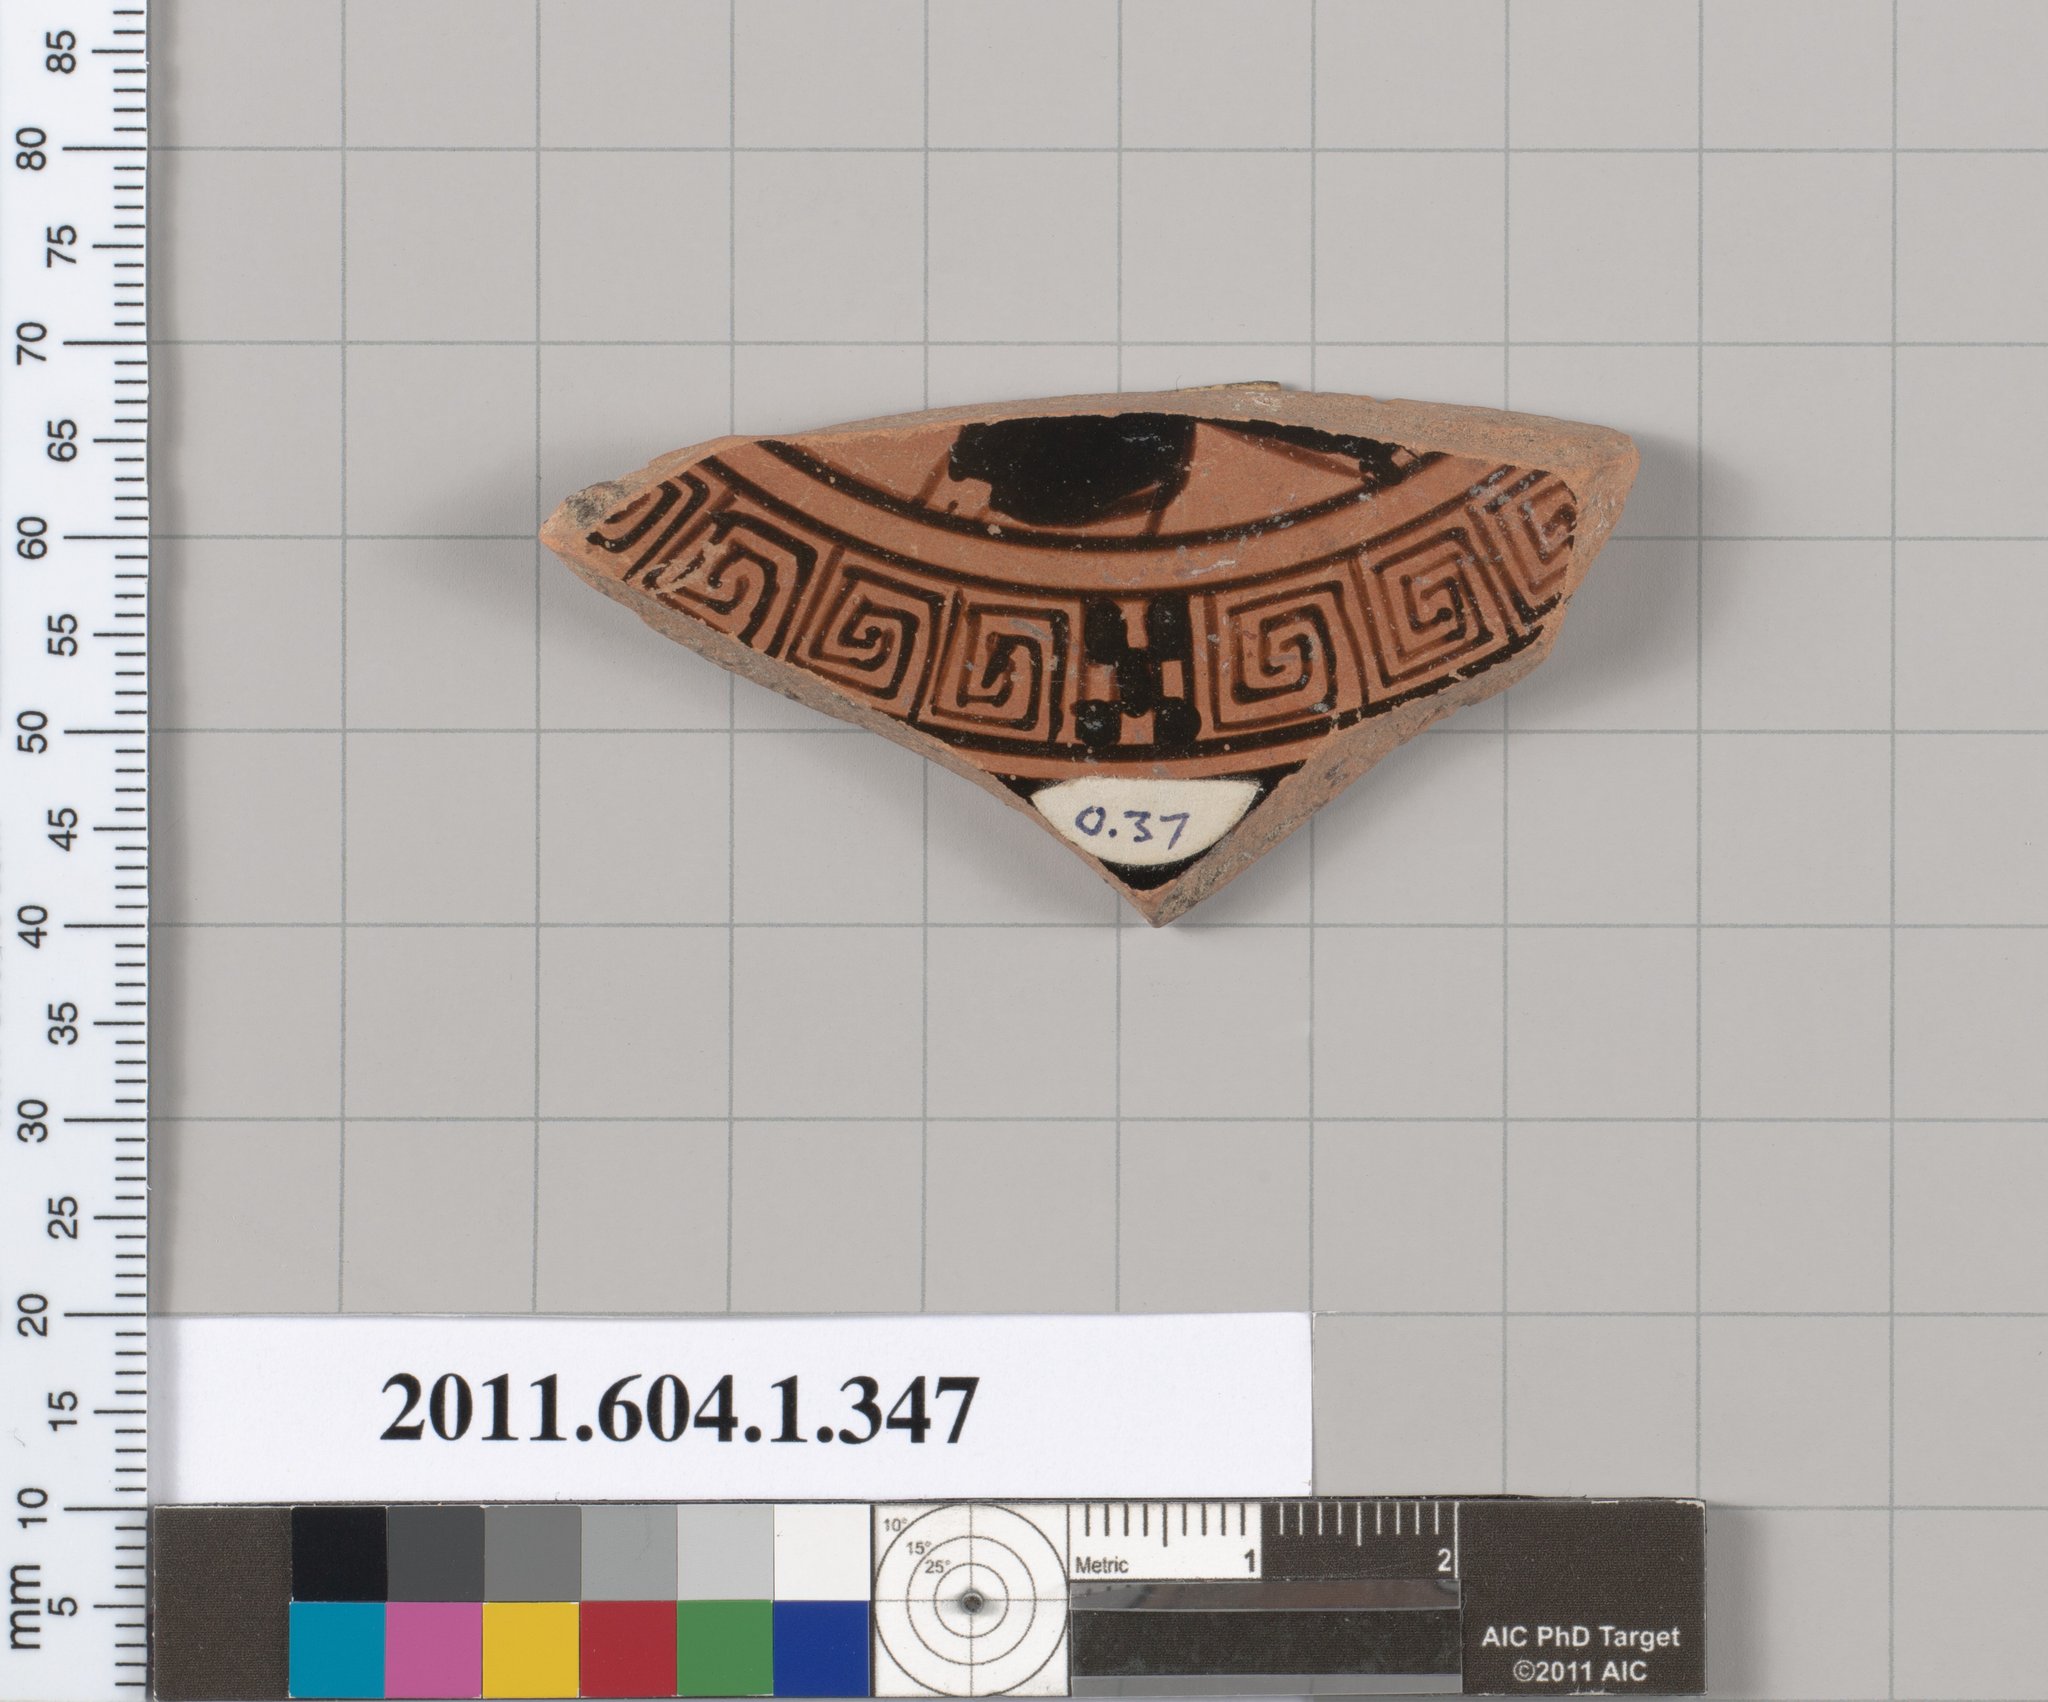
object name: kylix fragment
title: Terracotta fragment of a kylix (drinking cup)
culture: greek, attic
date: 475-451 BCE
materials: terracotta